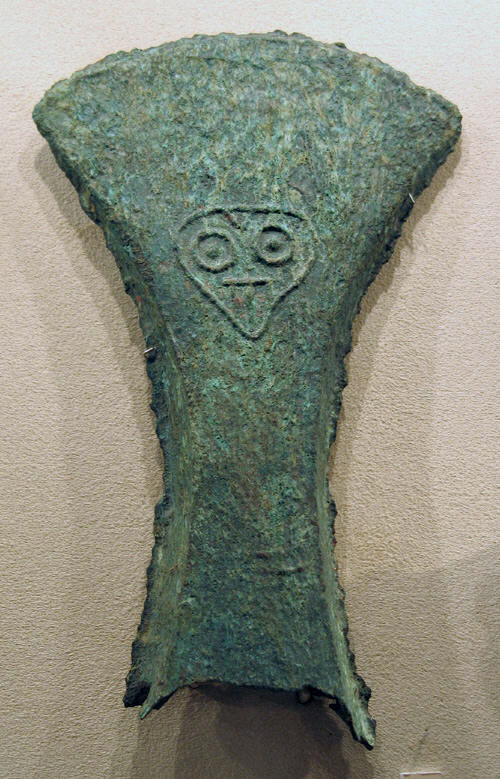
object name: ax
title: Hafted Ax with Moko-Style Face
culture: indonesian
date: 500 BCE-300 CE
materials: bronze